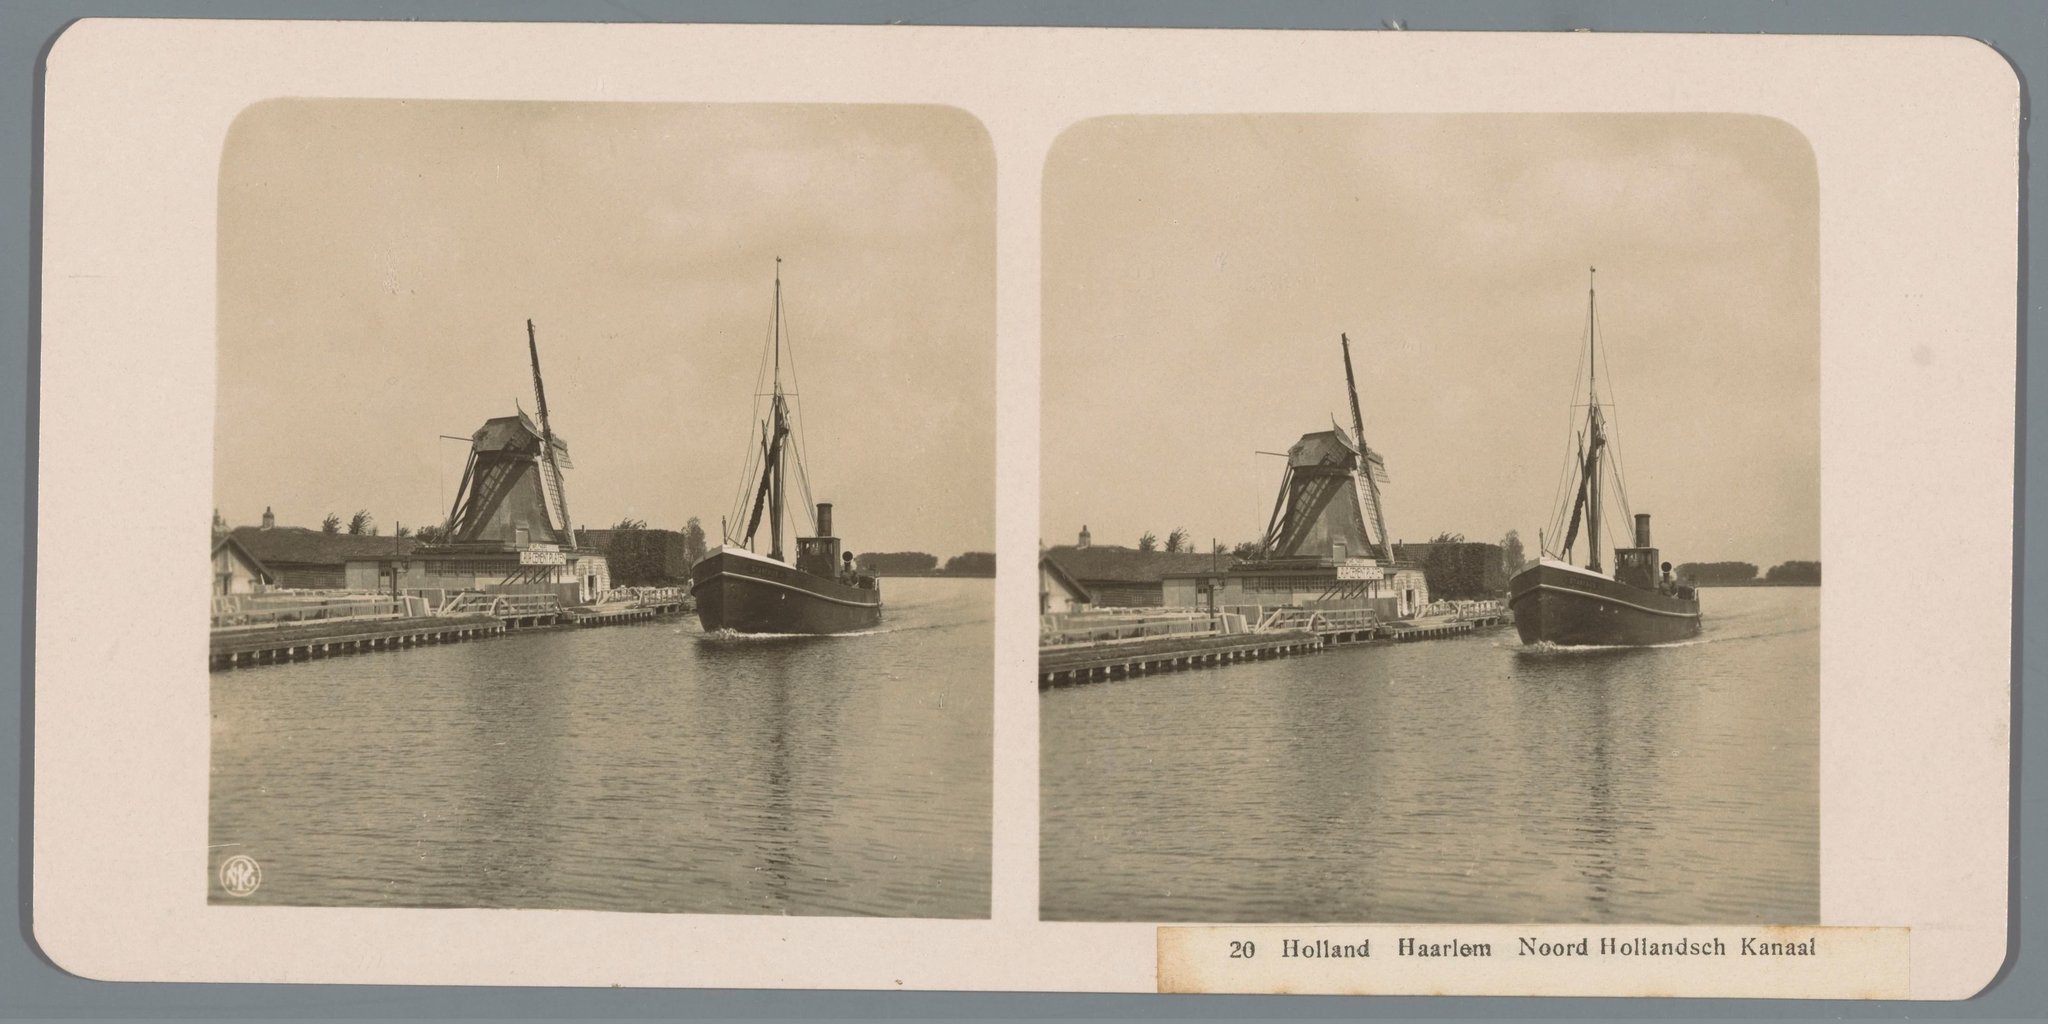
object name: stereograph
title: Gezicht op het Noordhollandsch Kanaal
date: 1900-1910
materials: cardboard, photographic support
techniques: gelatin silver print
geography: north holland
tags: canal, ships (in general), windmill in landscape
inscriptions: number: ‘20’, inscription: ‘NPG’